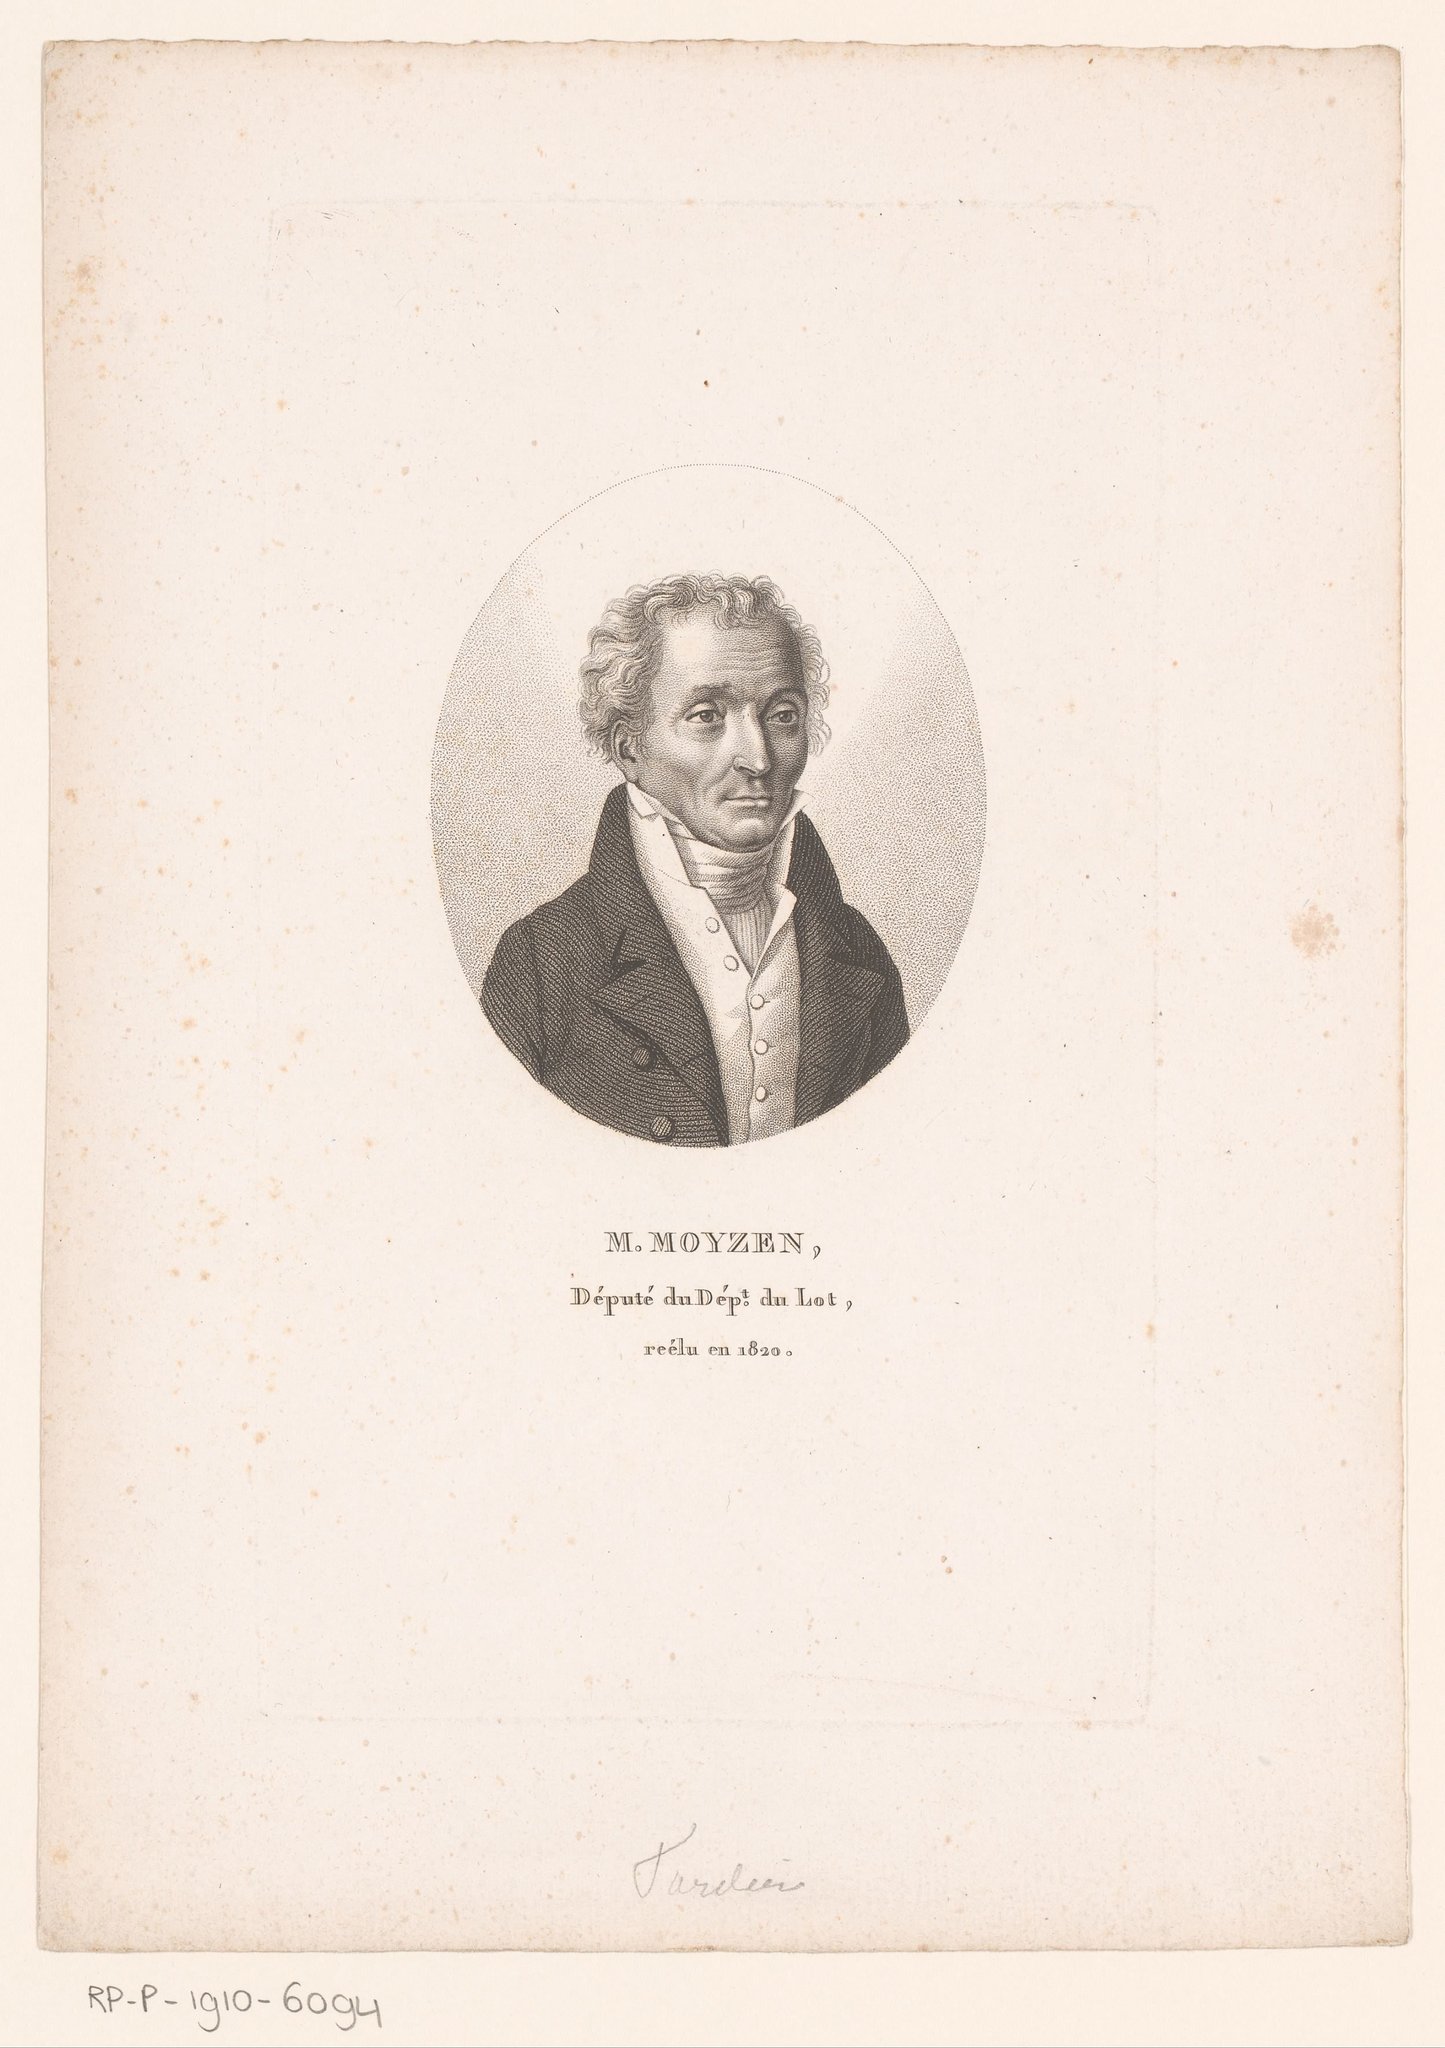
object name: print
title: Portret van Jean Joseph Moyzen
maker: ambroise tardieu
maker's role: print maker, printer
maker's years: 1788-1841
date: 1820-1821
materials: paper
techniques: engraving, roulette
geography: paris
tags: politician, historical persons, politician, e.g. party leader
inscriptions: collector's mark: Lugt 2228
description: Prent uit: Tardieu, Ambroise. Portraits des députés, écrivains et pairs constitutionnels, défenseurs invariables de la charte et de la loi des élections du 5 février 1817. Parijs: Tardieu, Ambroise, 1820-1821.